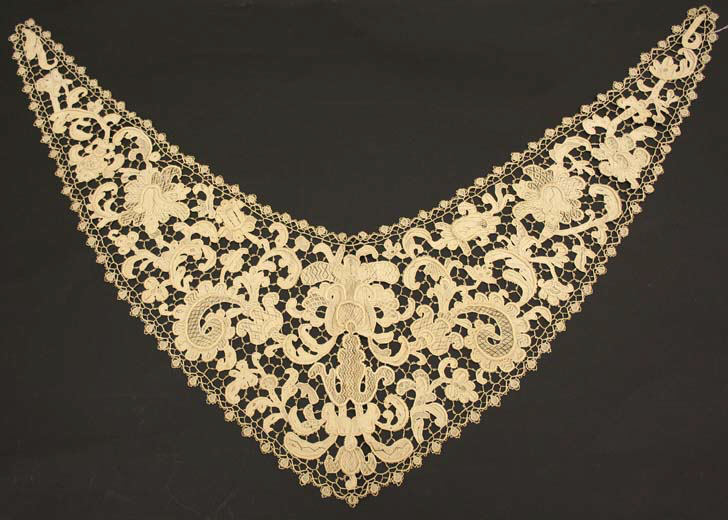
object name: bertha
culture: italian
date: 1801-1900